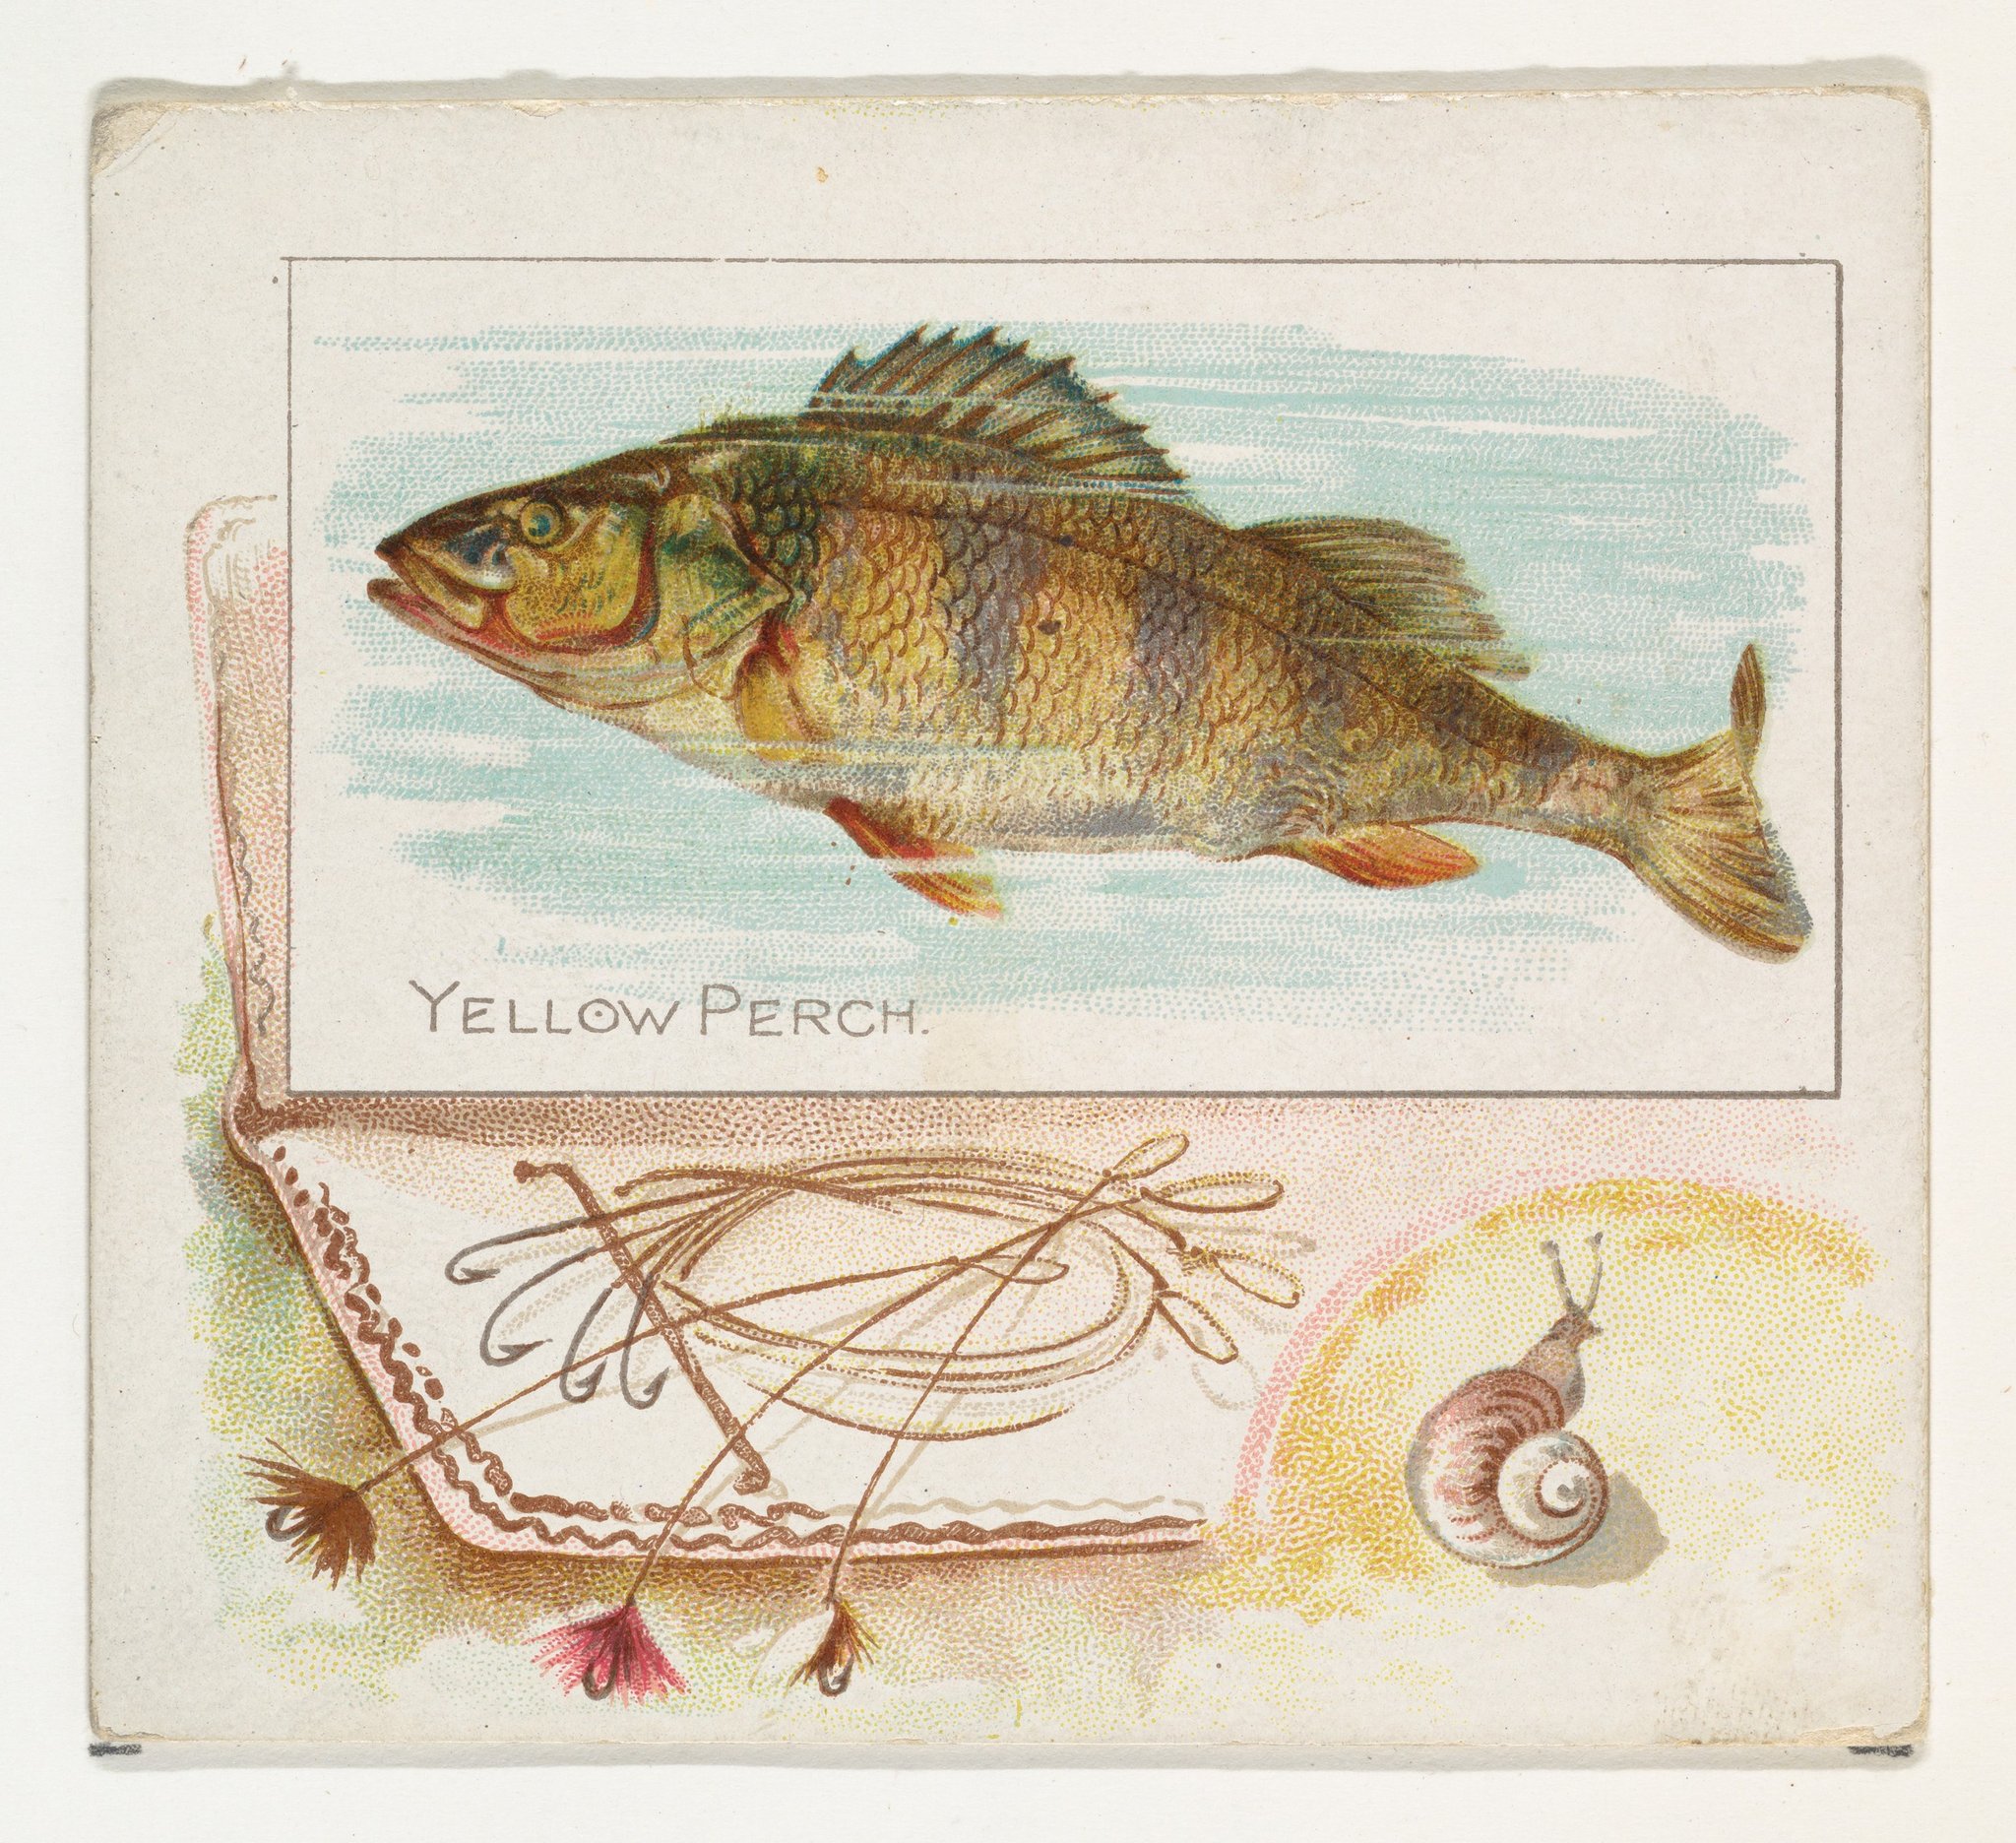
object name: print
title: Yellow Perch, from Fish from American Waters series (N39) for Allen & Ginter Cigarettes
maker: allen & ginter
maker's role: publisher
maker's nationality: american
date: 1889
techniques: color lithograph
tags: fish,snails